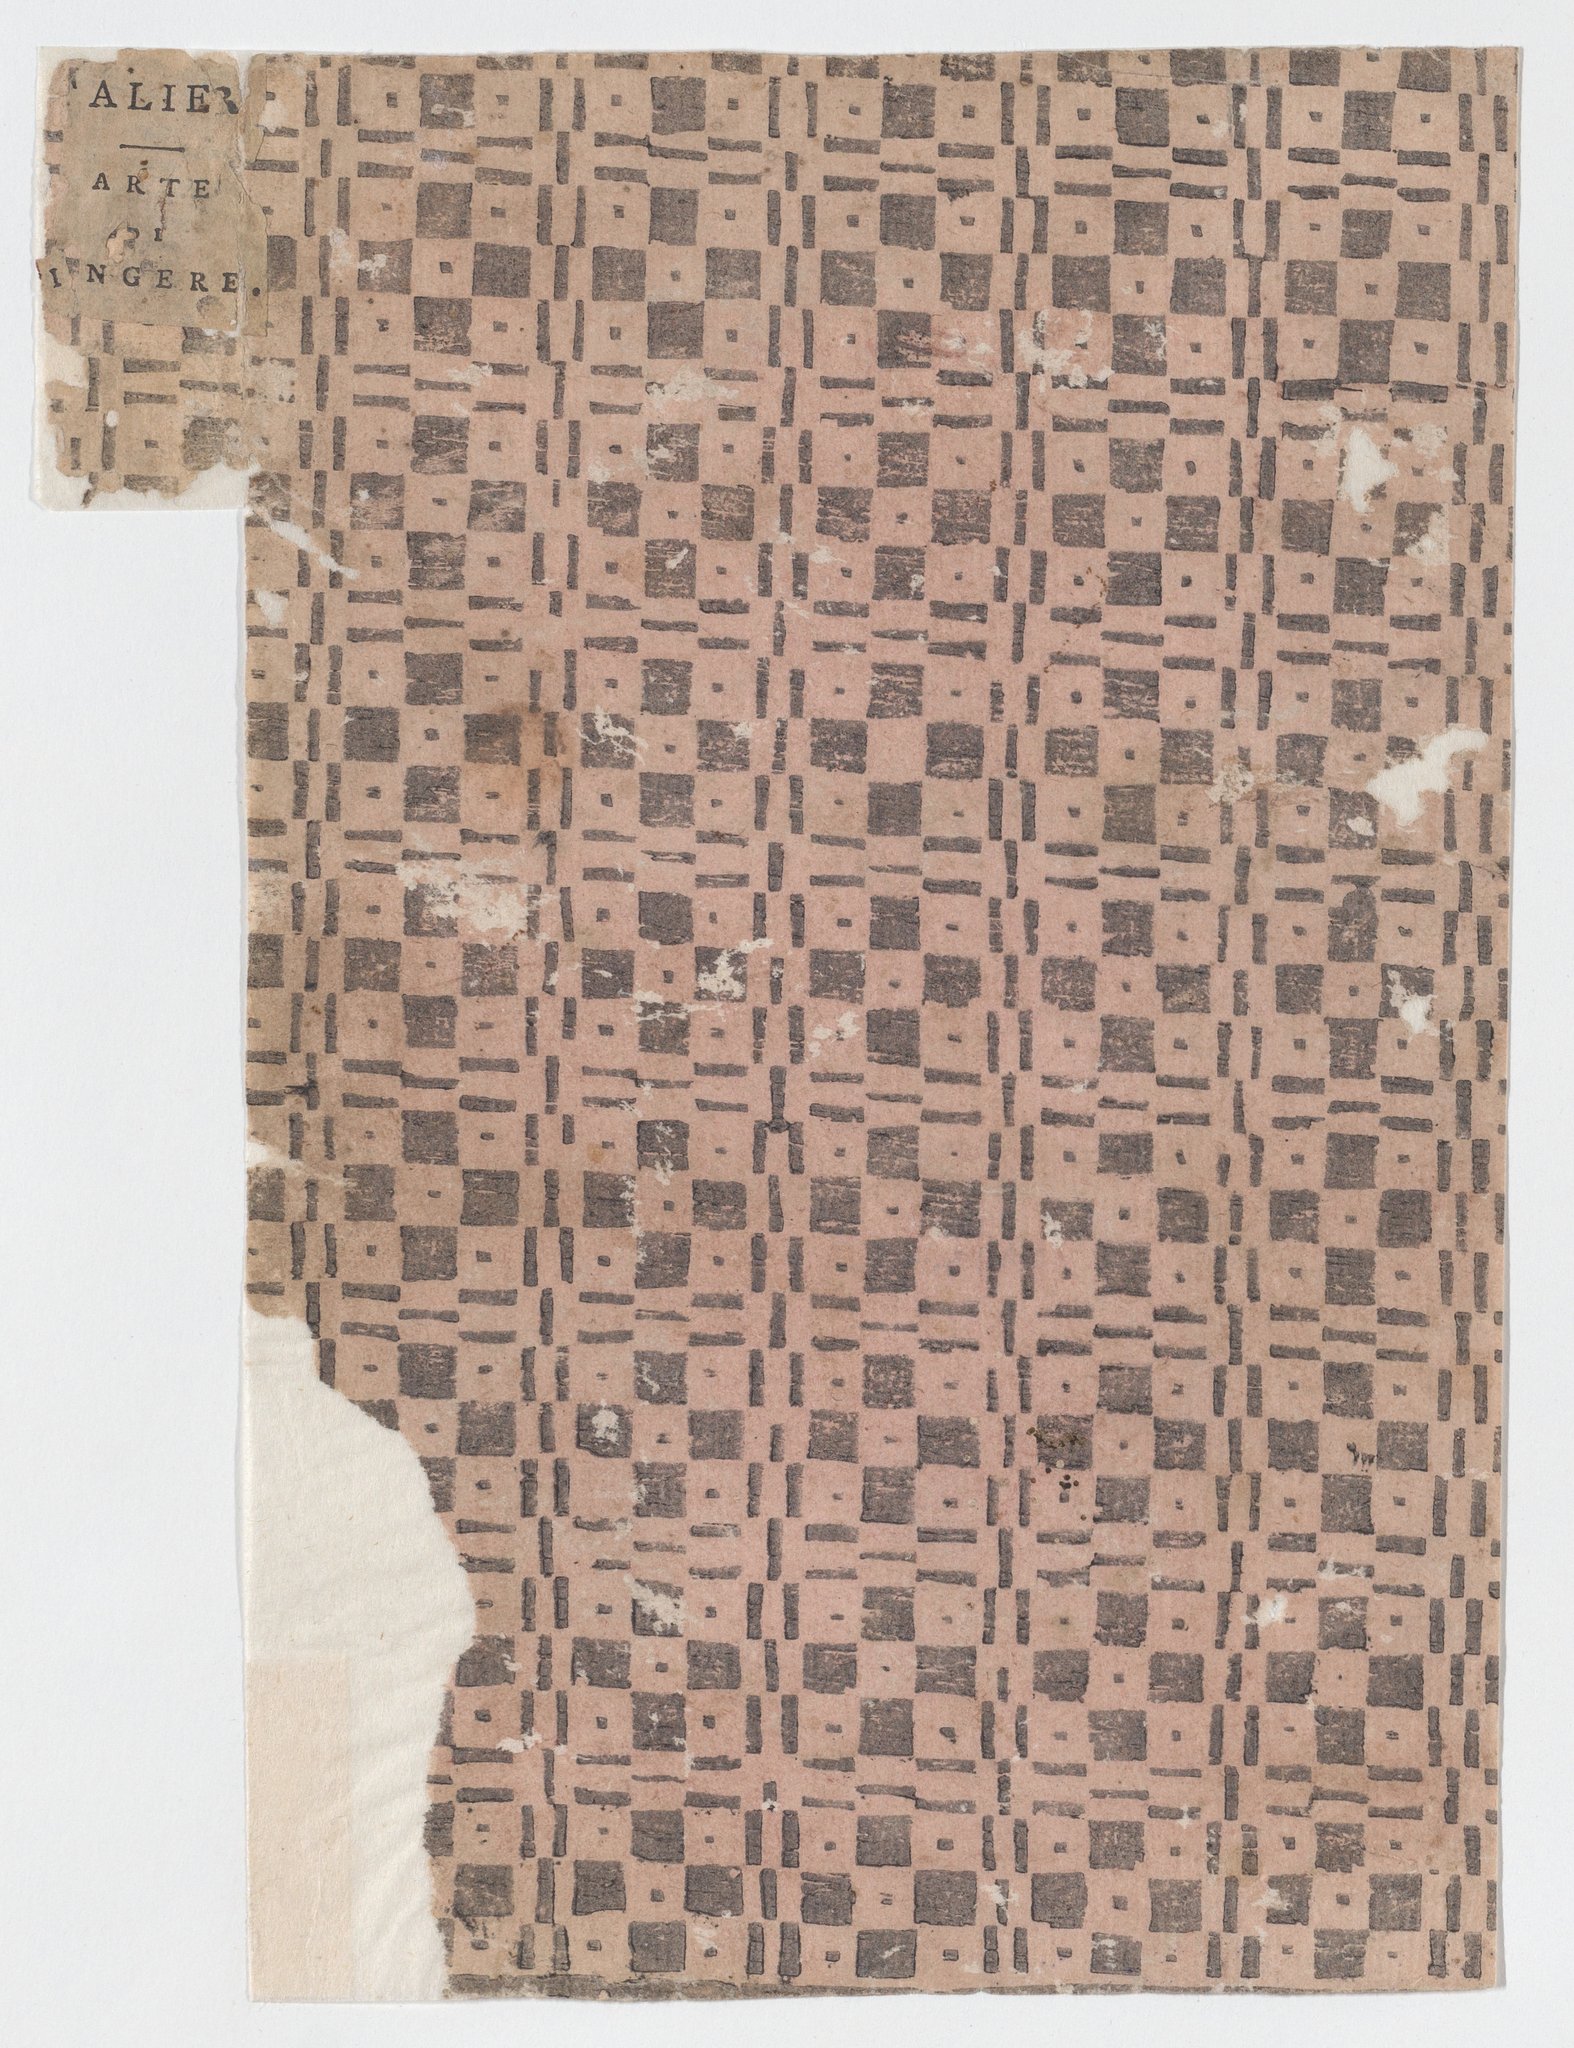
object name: print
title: Sheet with overall checkerboard pattern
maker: Anonymous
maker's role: artist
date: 1801-1900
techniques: relief print